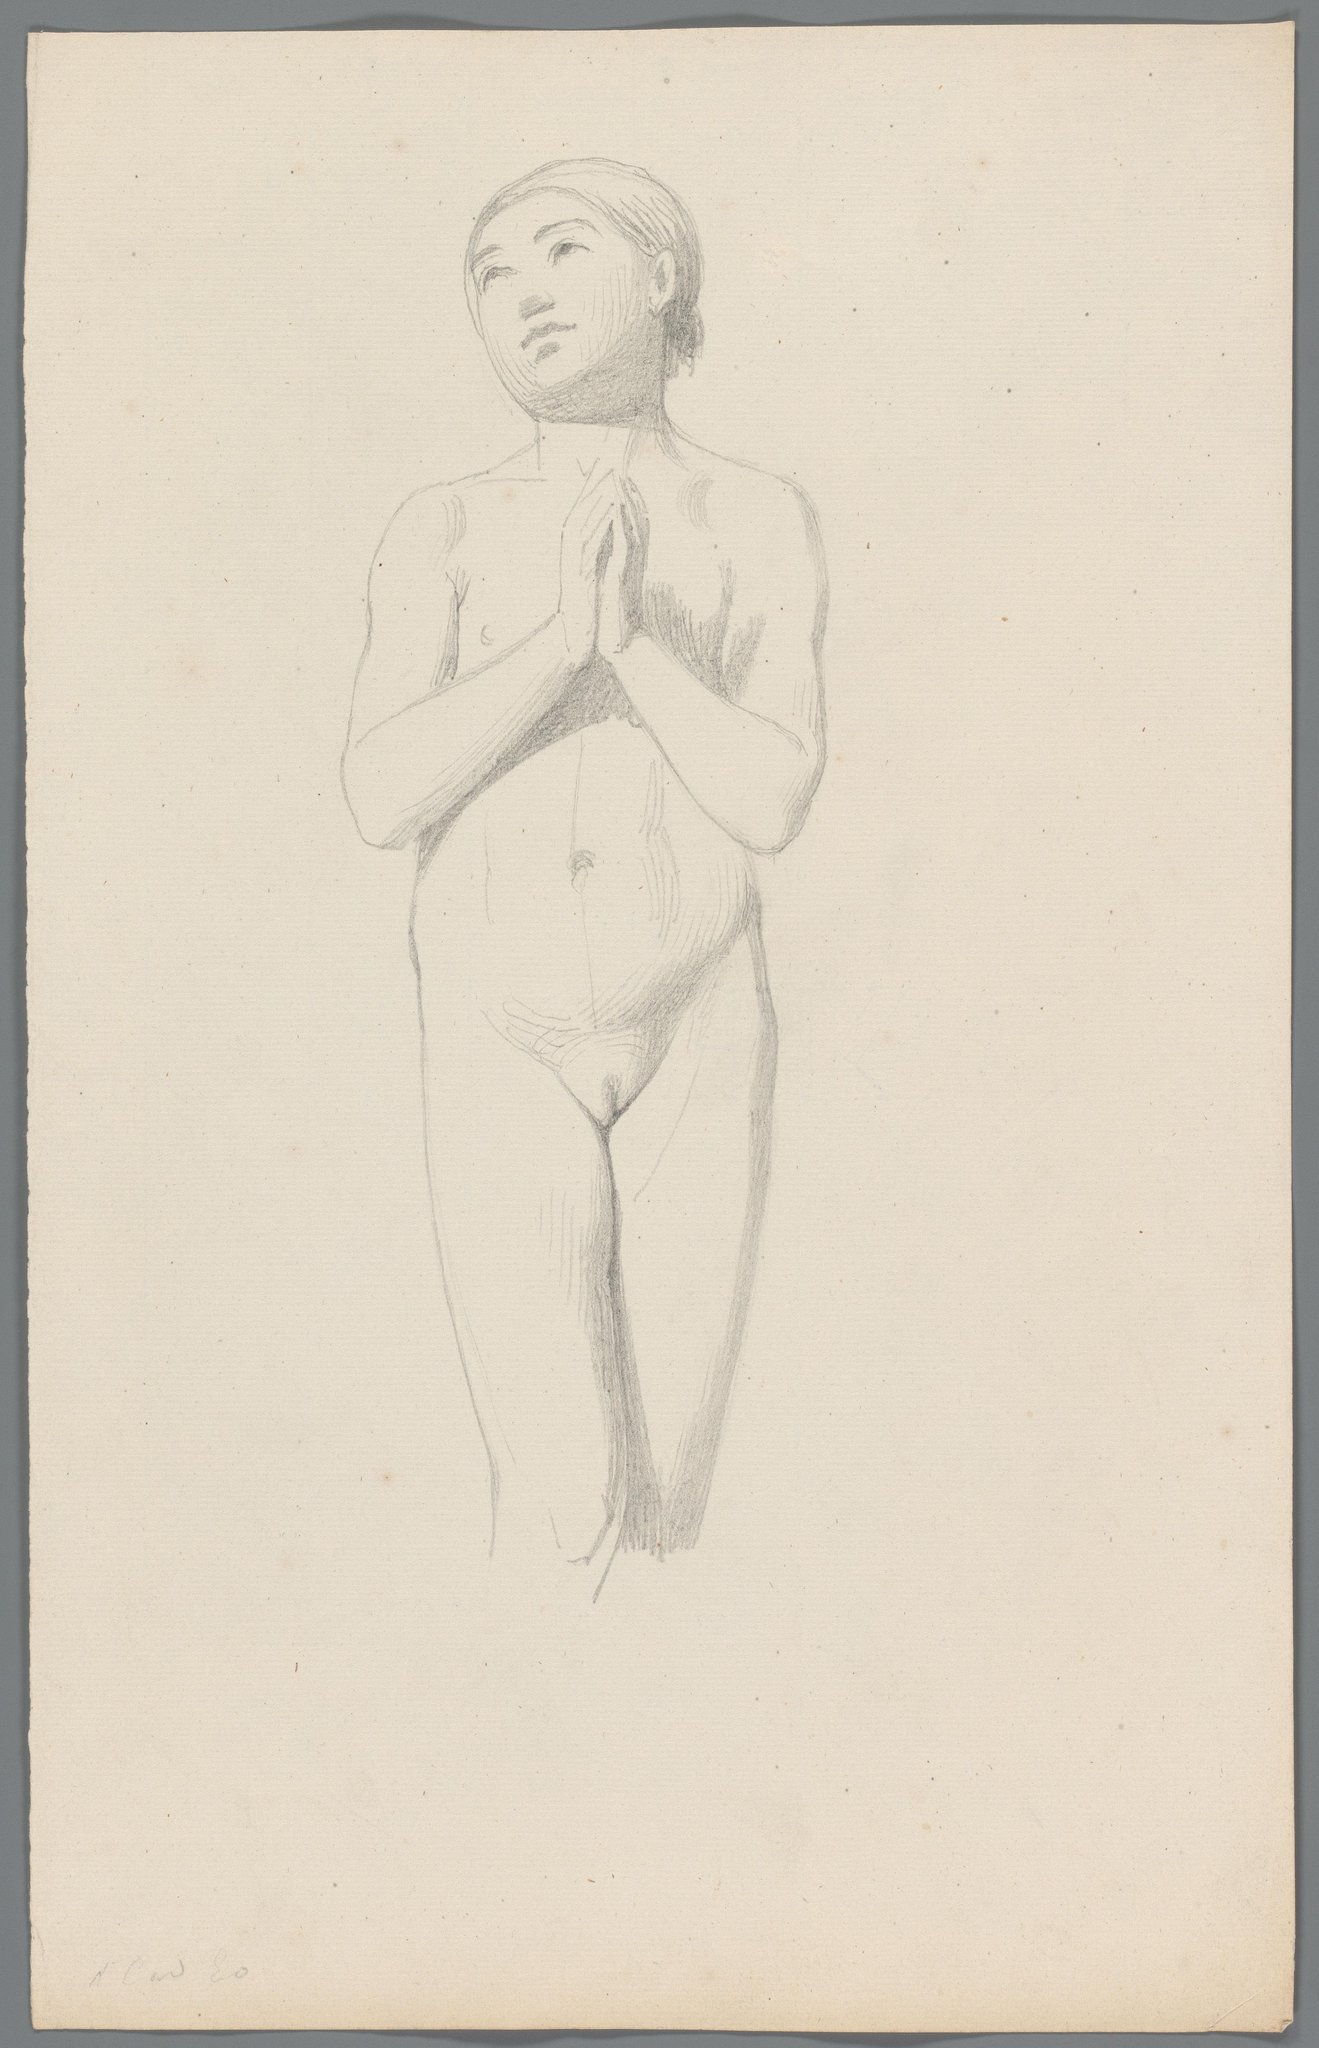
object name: drawing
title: Studie van een naakt meisje met gevouwen handen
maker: jacobus everhardus josephus van den berg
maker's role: draughtsman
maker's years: 1802-1861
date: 1850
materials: paper, pencil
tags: postures and gestures of arms and hands in relation to each other, child (at home) - aa - girl, the (nude) human figure; 'corpo humano' (ripa) - aa - female human figure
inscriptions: inscription: ‘[...] EO’